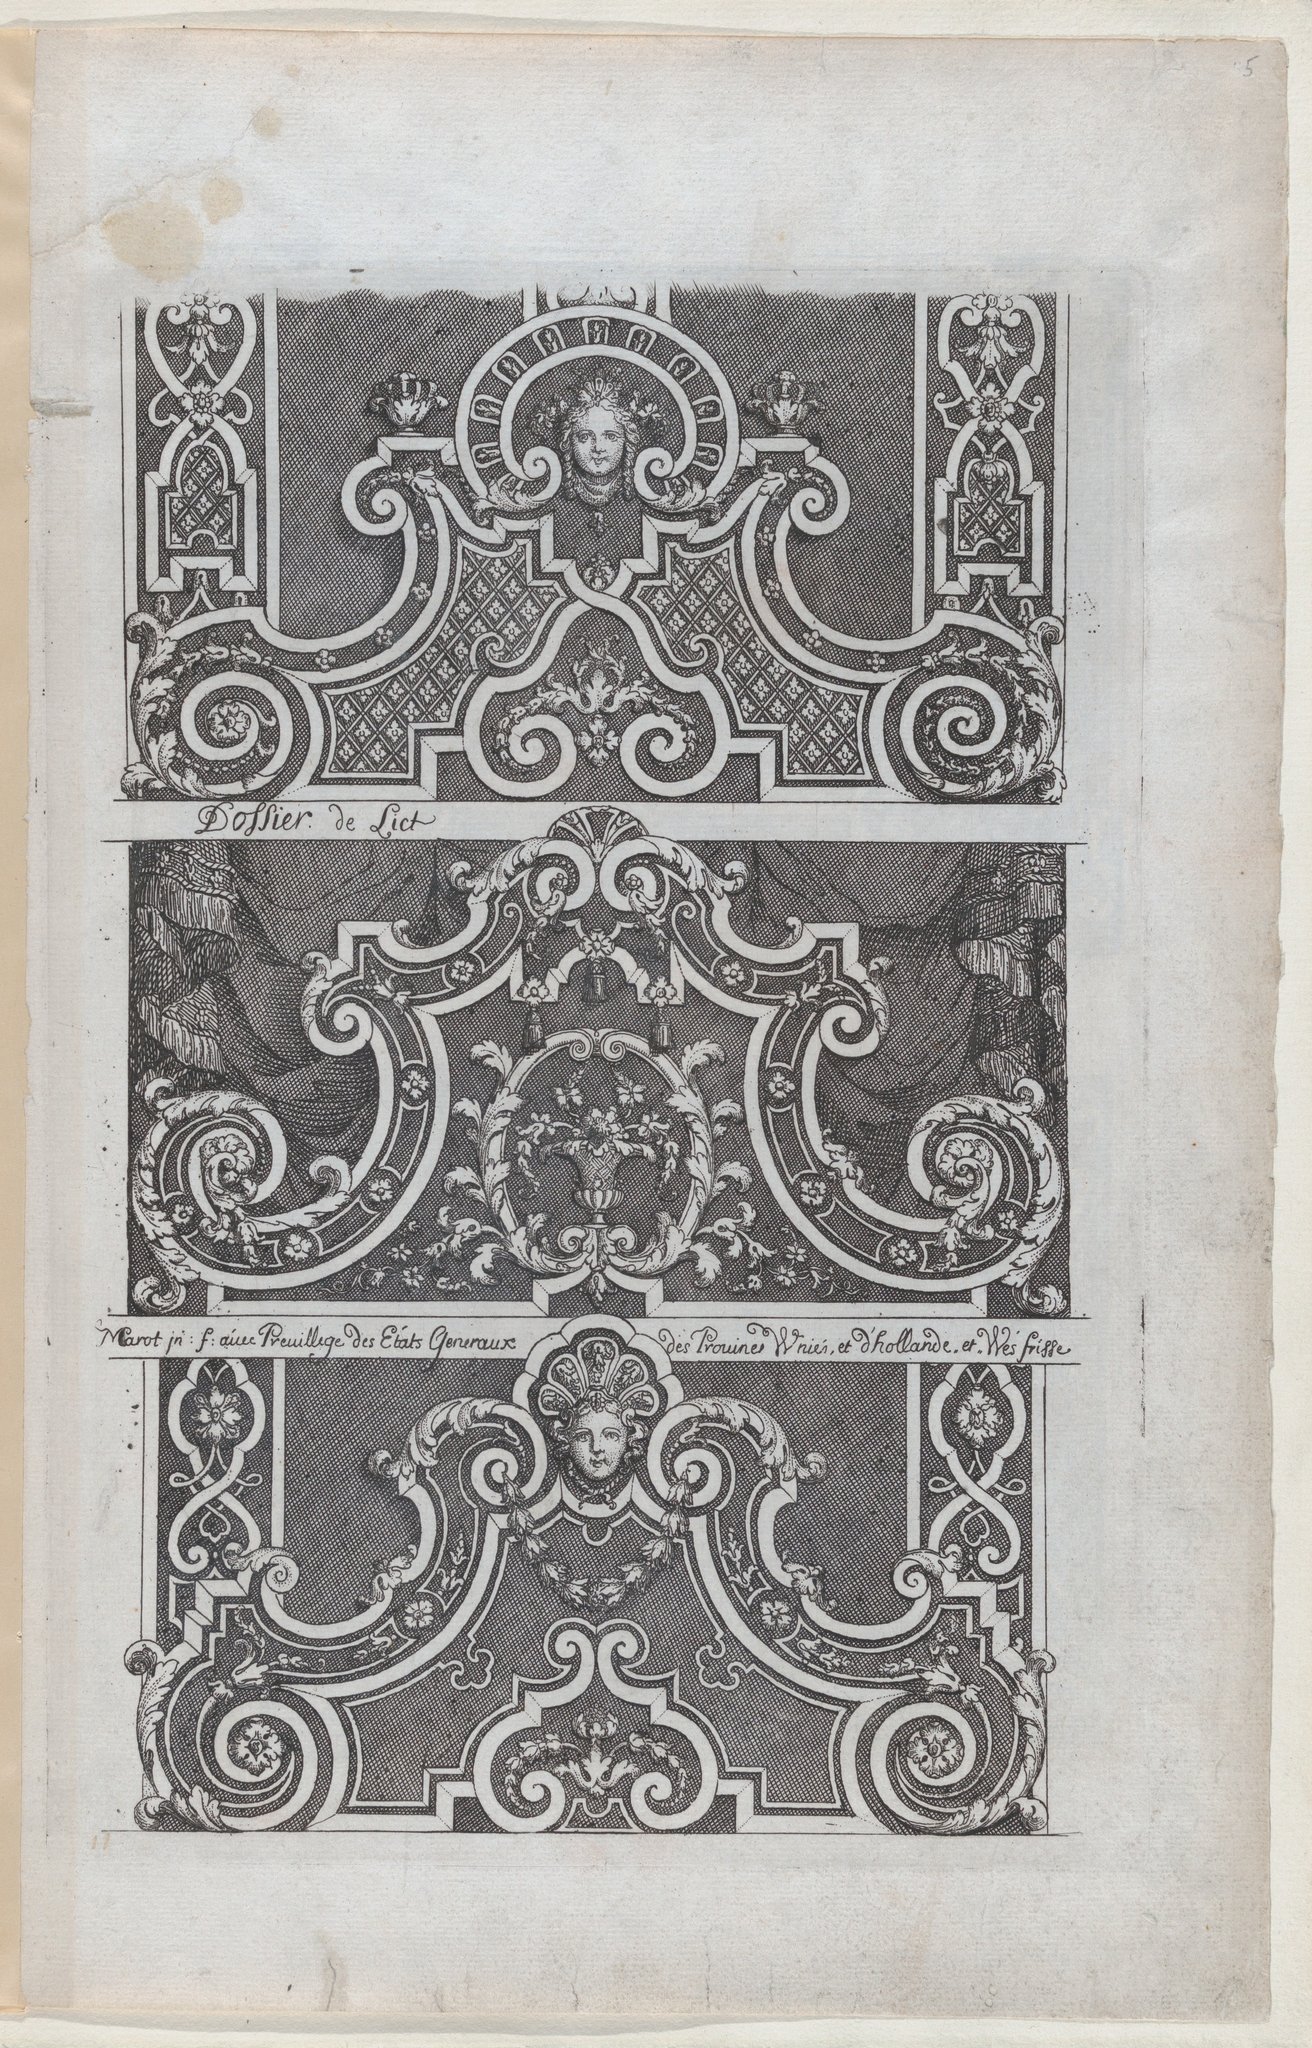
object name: print collection ornament architecture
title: Three Designs for Embroidered Headboards, from Nouveaux Liure da Partements, part of Œuvres du Sr. D. Marot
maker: daniel marot the elder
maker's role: artist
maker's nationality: french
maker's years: 1661-1752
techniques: etching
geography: netherlands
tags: ornament